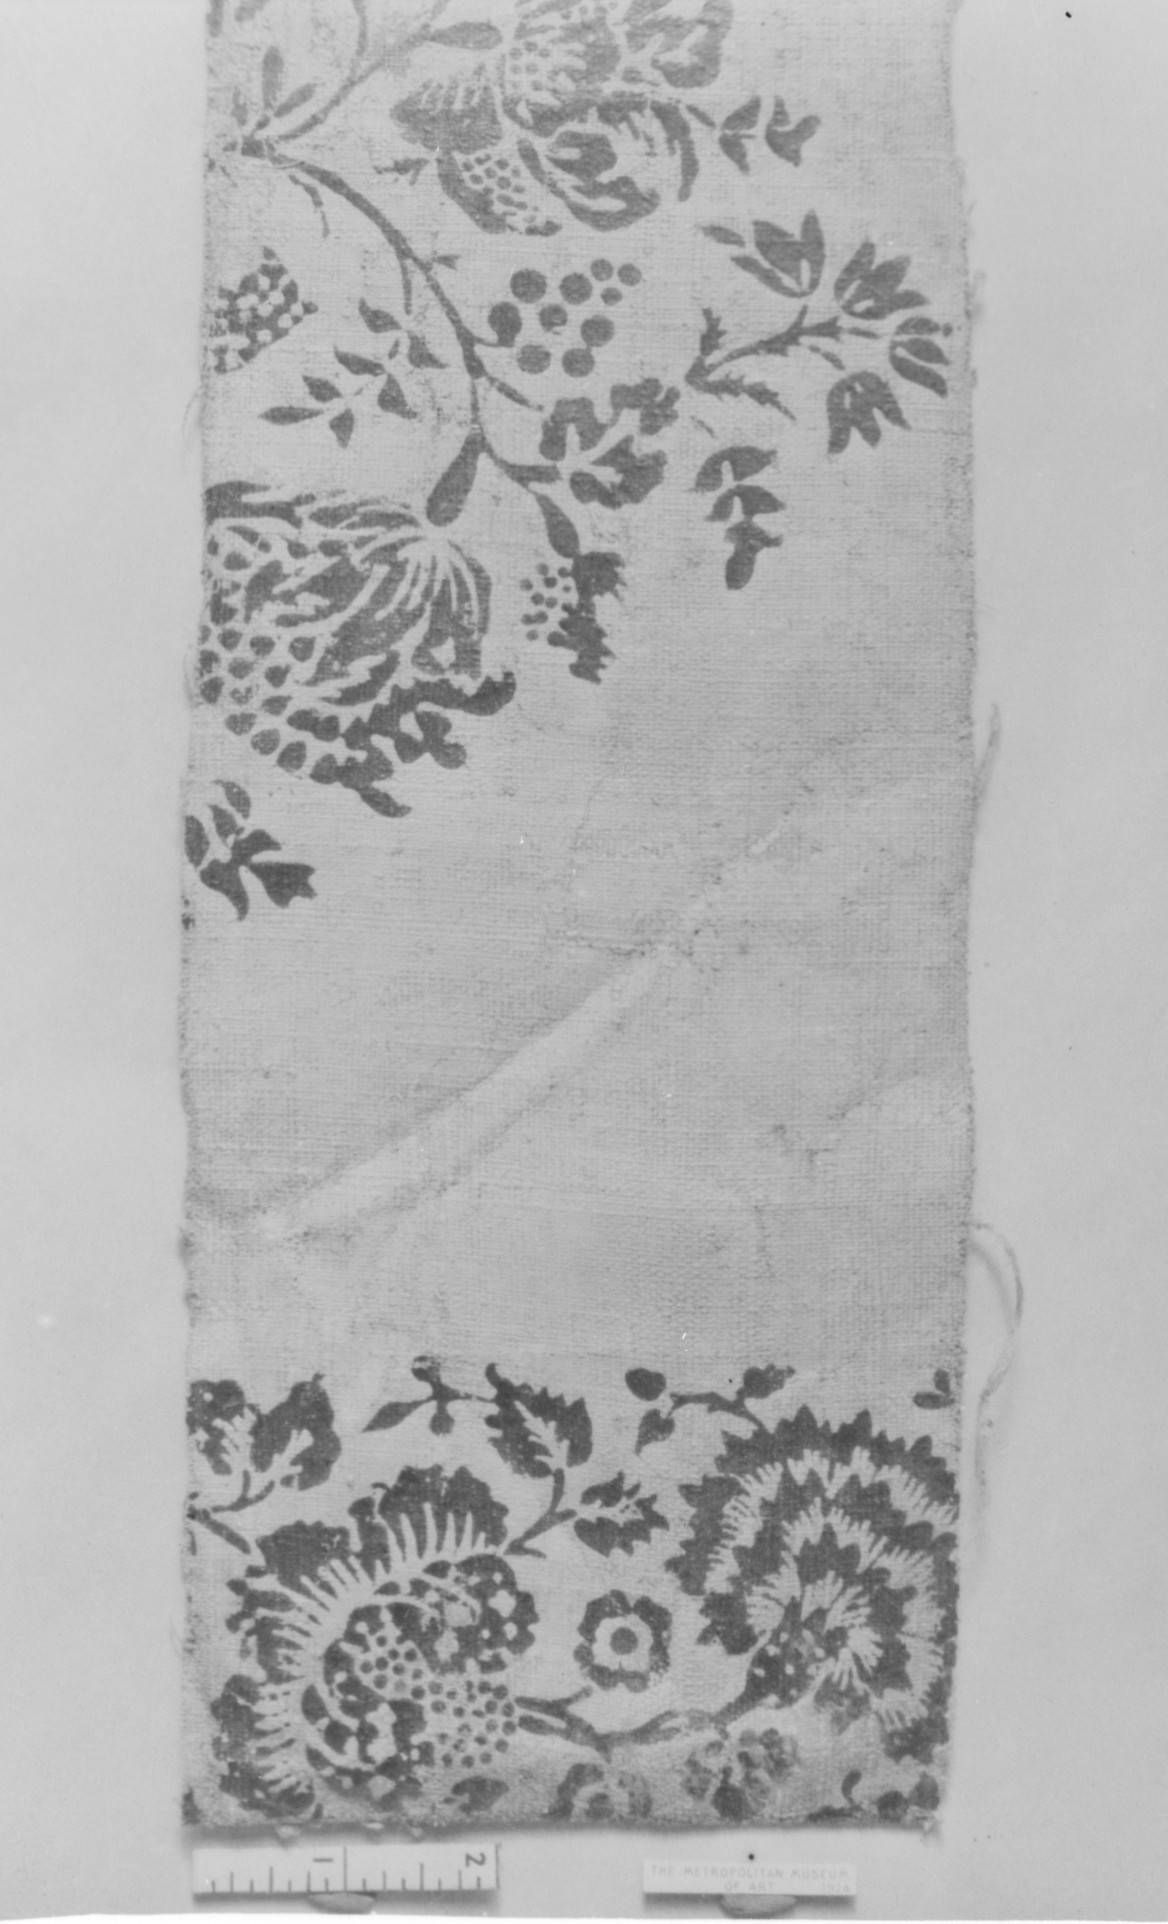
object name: wall covering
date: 1701-1800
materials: canvas, oil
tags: flowers